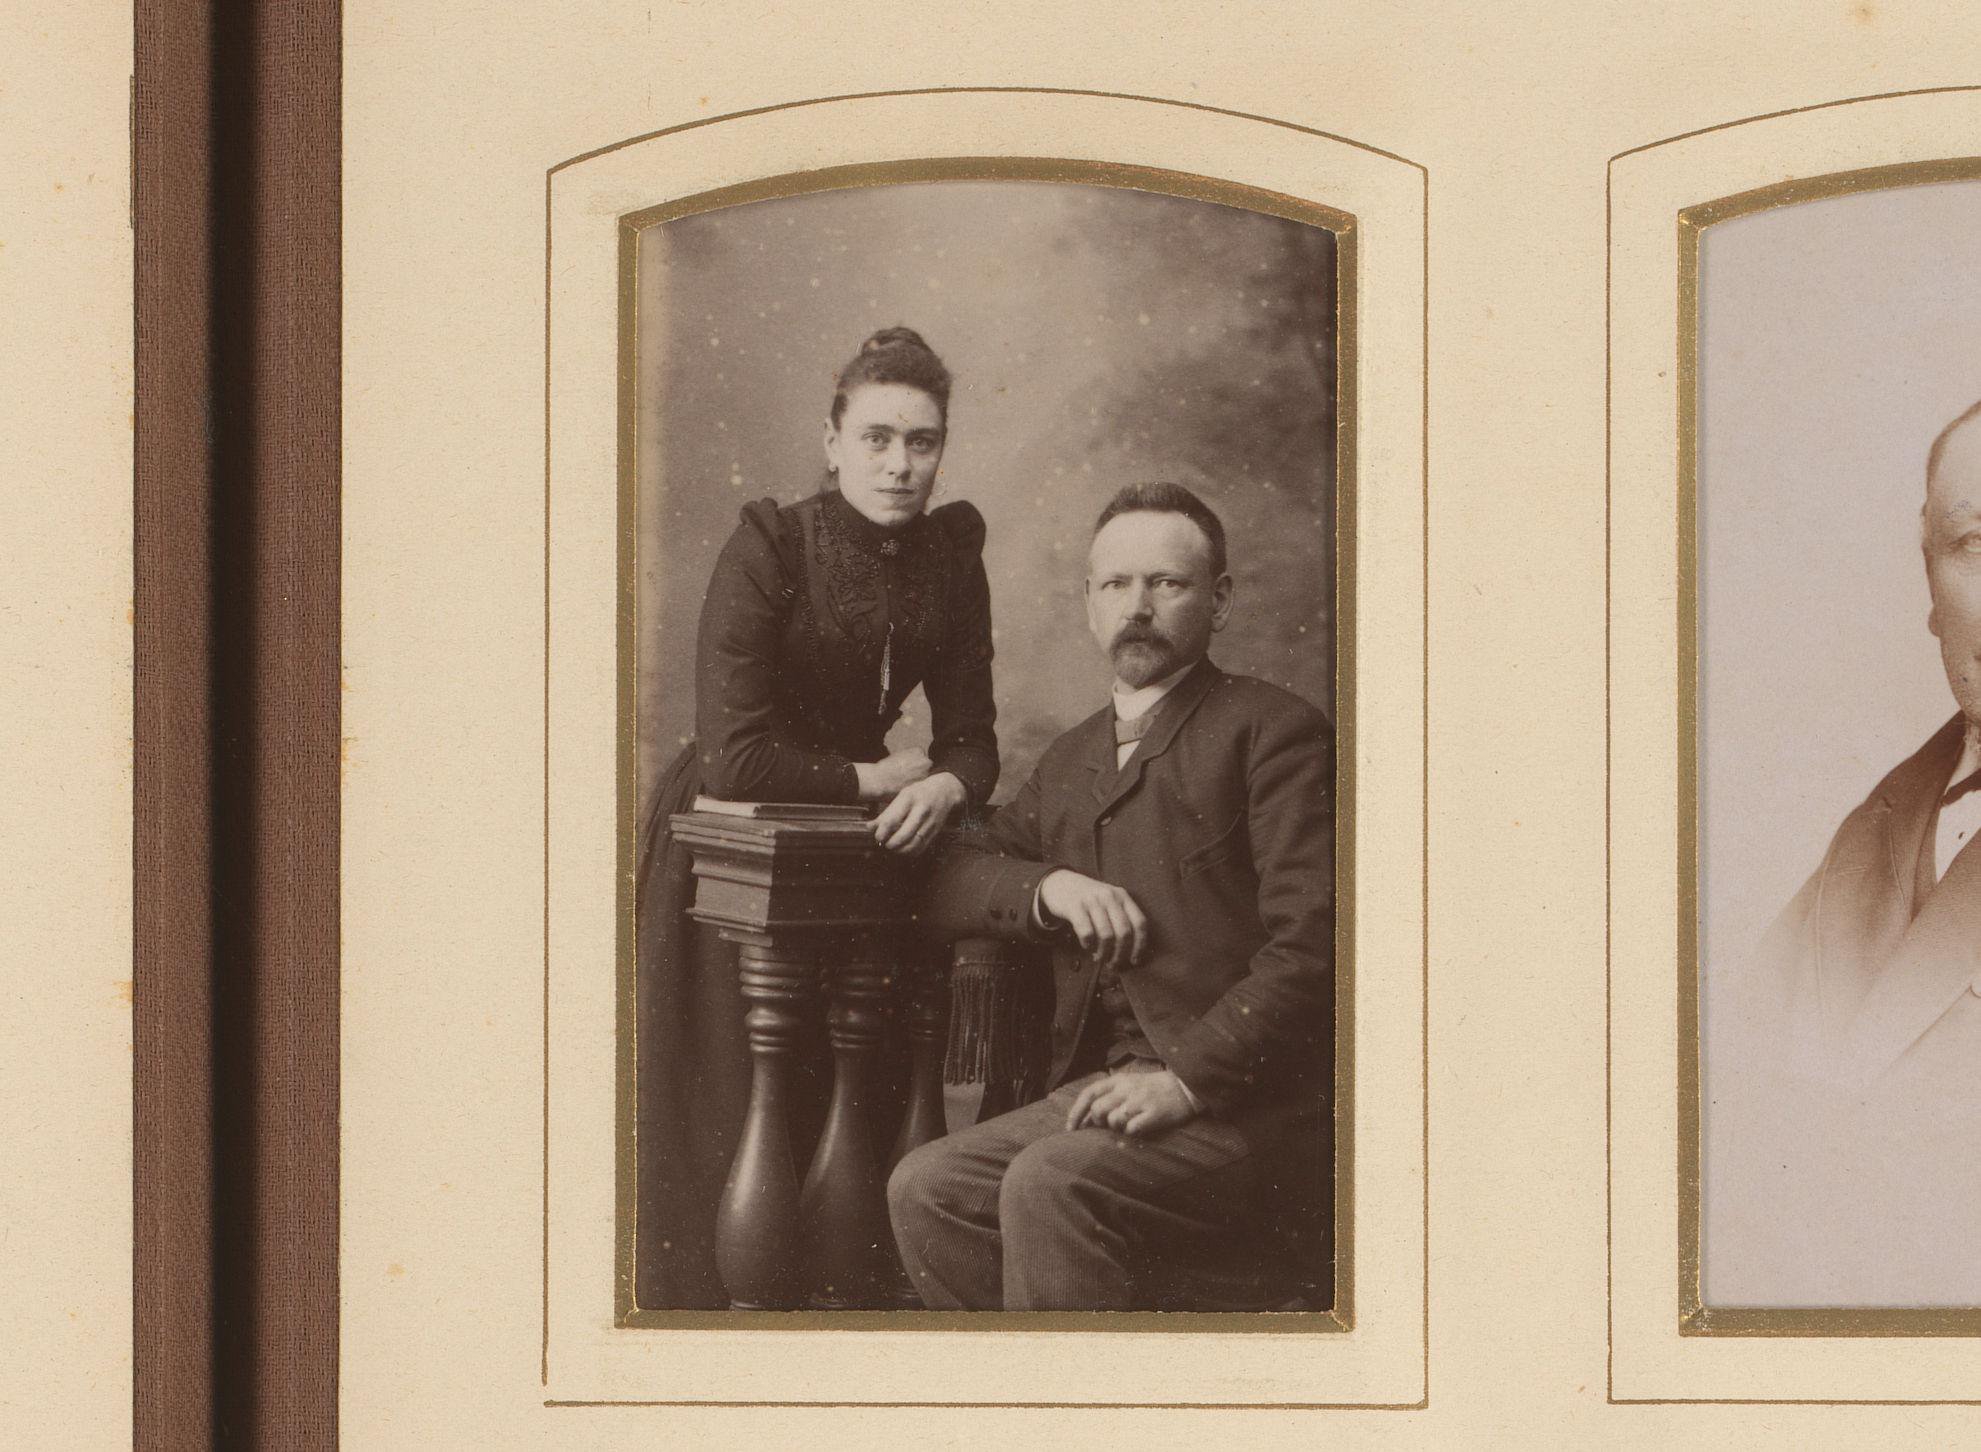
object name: album leaf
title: Portret van een staande vrouw en een zittende man bij een balustrade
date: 1885-1906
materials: cardboard, photographic support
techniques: albumen print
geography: amsterdam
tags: historical persons - bb - woman, historical persons, balustrade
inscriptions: inscription: ‘W.G. Kuijer & Zonen/ Hofphotographen/ Amsterdam/ Westermarkt 19./ Spéciale Inrichting/ voor/ VERGROOTINGEN/ in alle Formaten.’